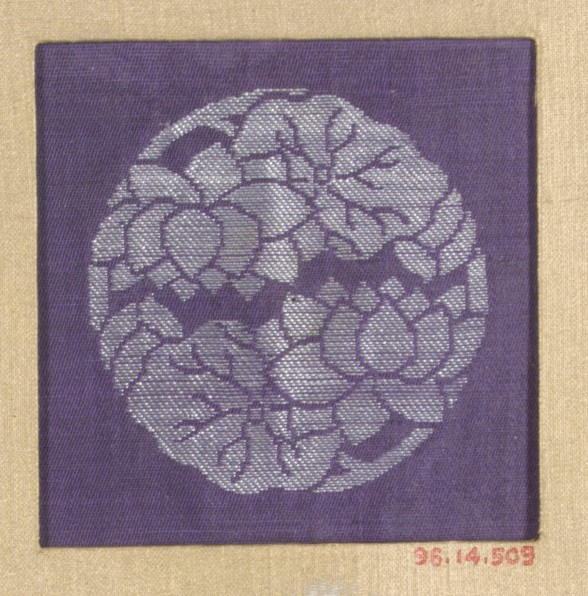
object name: piece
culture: japanese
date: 1701-1900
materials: silk